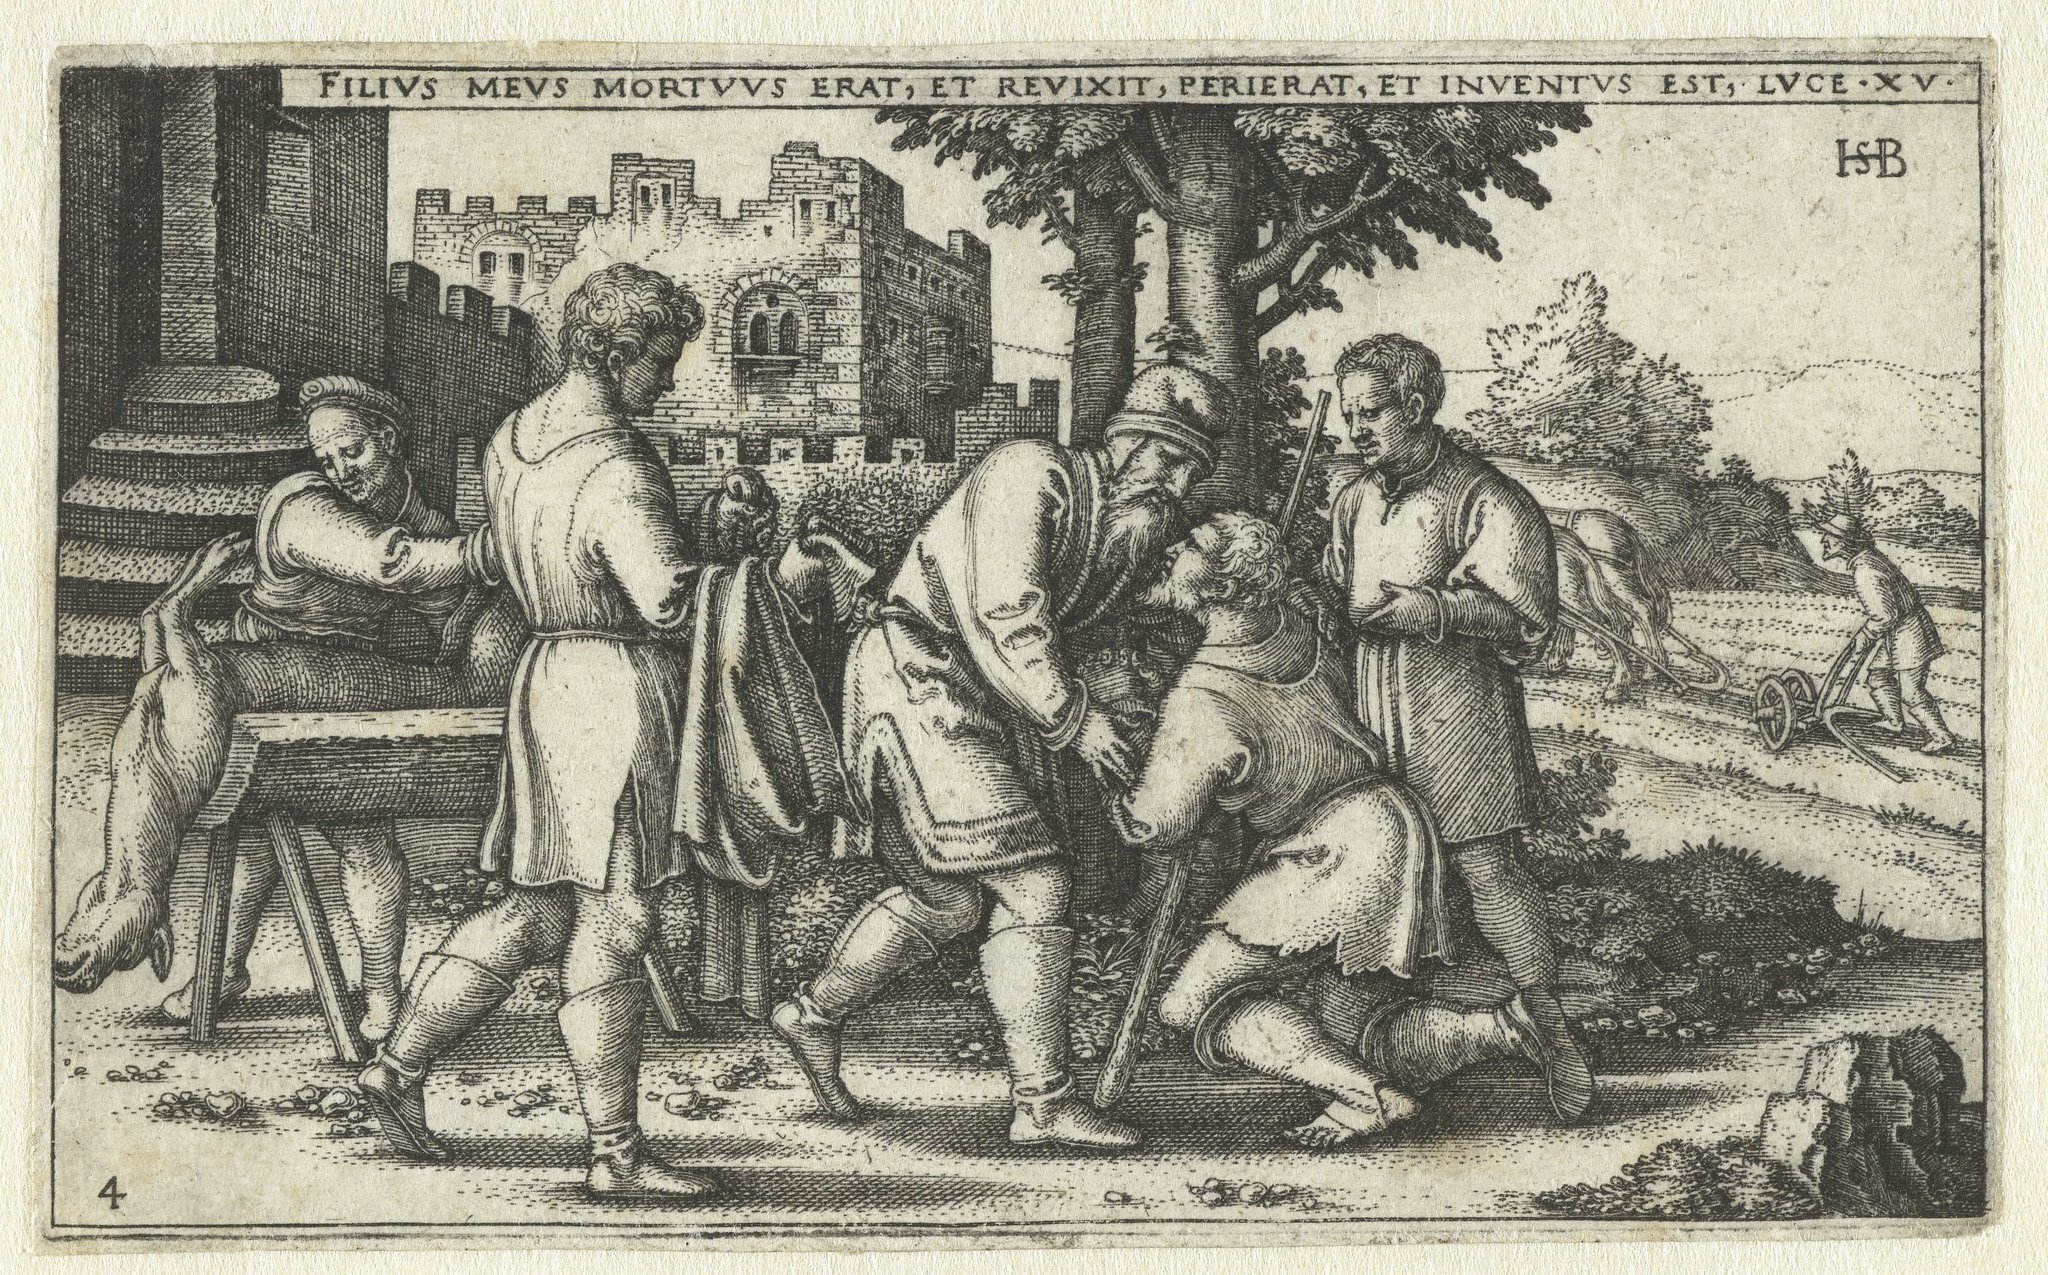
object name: print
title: Verhaal van de Verloren Zoon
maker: hans sebald beham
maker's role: designer, draughtsman, print maker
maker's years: 1500-1550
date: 1540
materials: paper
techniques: engraving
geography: frankfurt am main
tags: the prodigal son returns home, where his father awaits him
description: Boven de voorstelling staat een Latijse bijbeltekst uit het boek Lucas: Filivs mevs mortvvs erat, et revixit, perierat, et inventvs est, Lvce XV